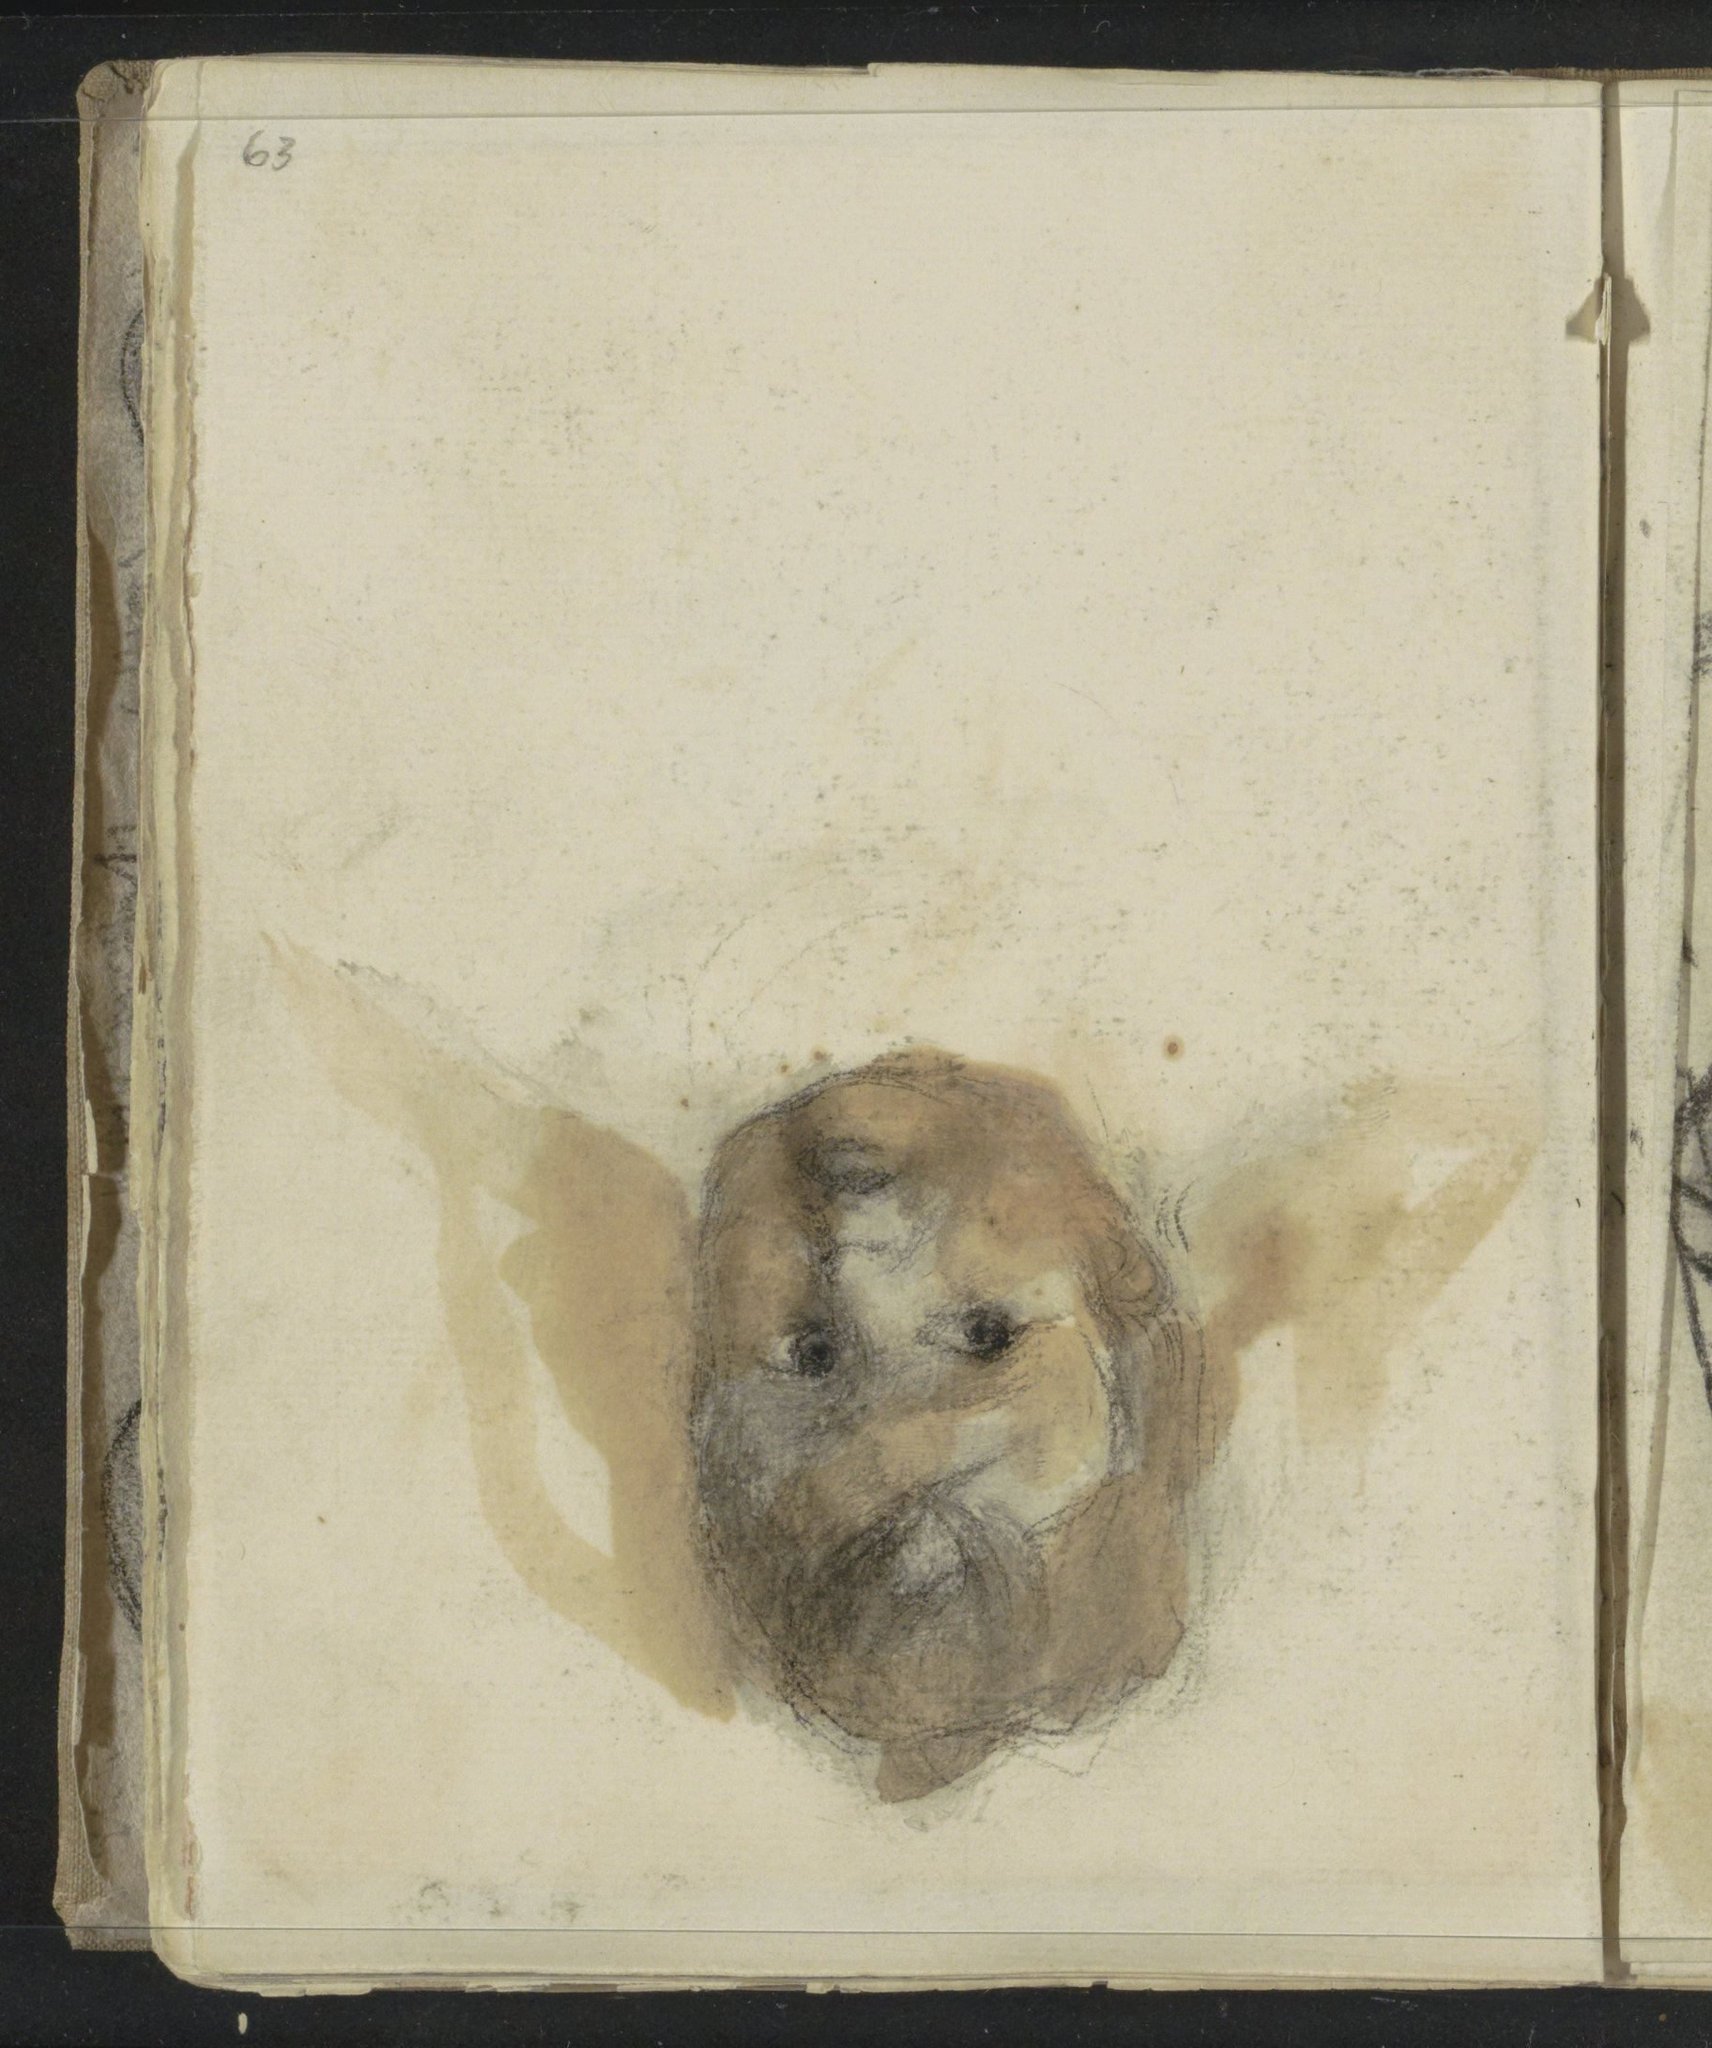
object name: sketchbook leaf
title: Kinderhoofd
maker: floris arntzenius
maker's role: draughtsman, print maker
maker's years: 1864-1925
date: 1883-1914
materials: chalk, paper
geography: the hague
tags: head (human), child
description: Pagina 63 uit een schetsboek met 82 pagina's.